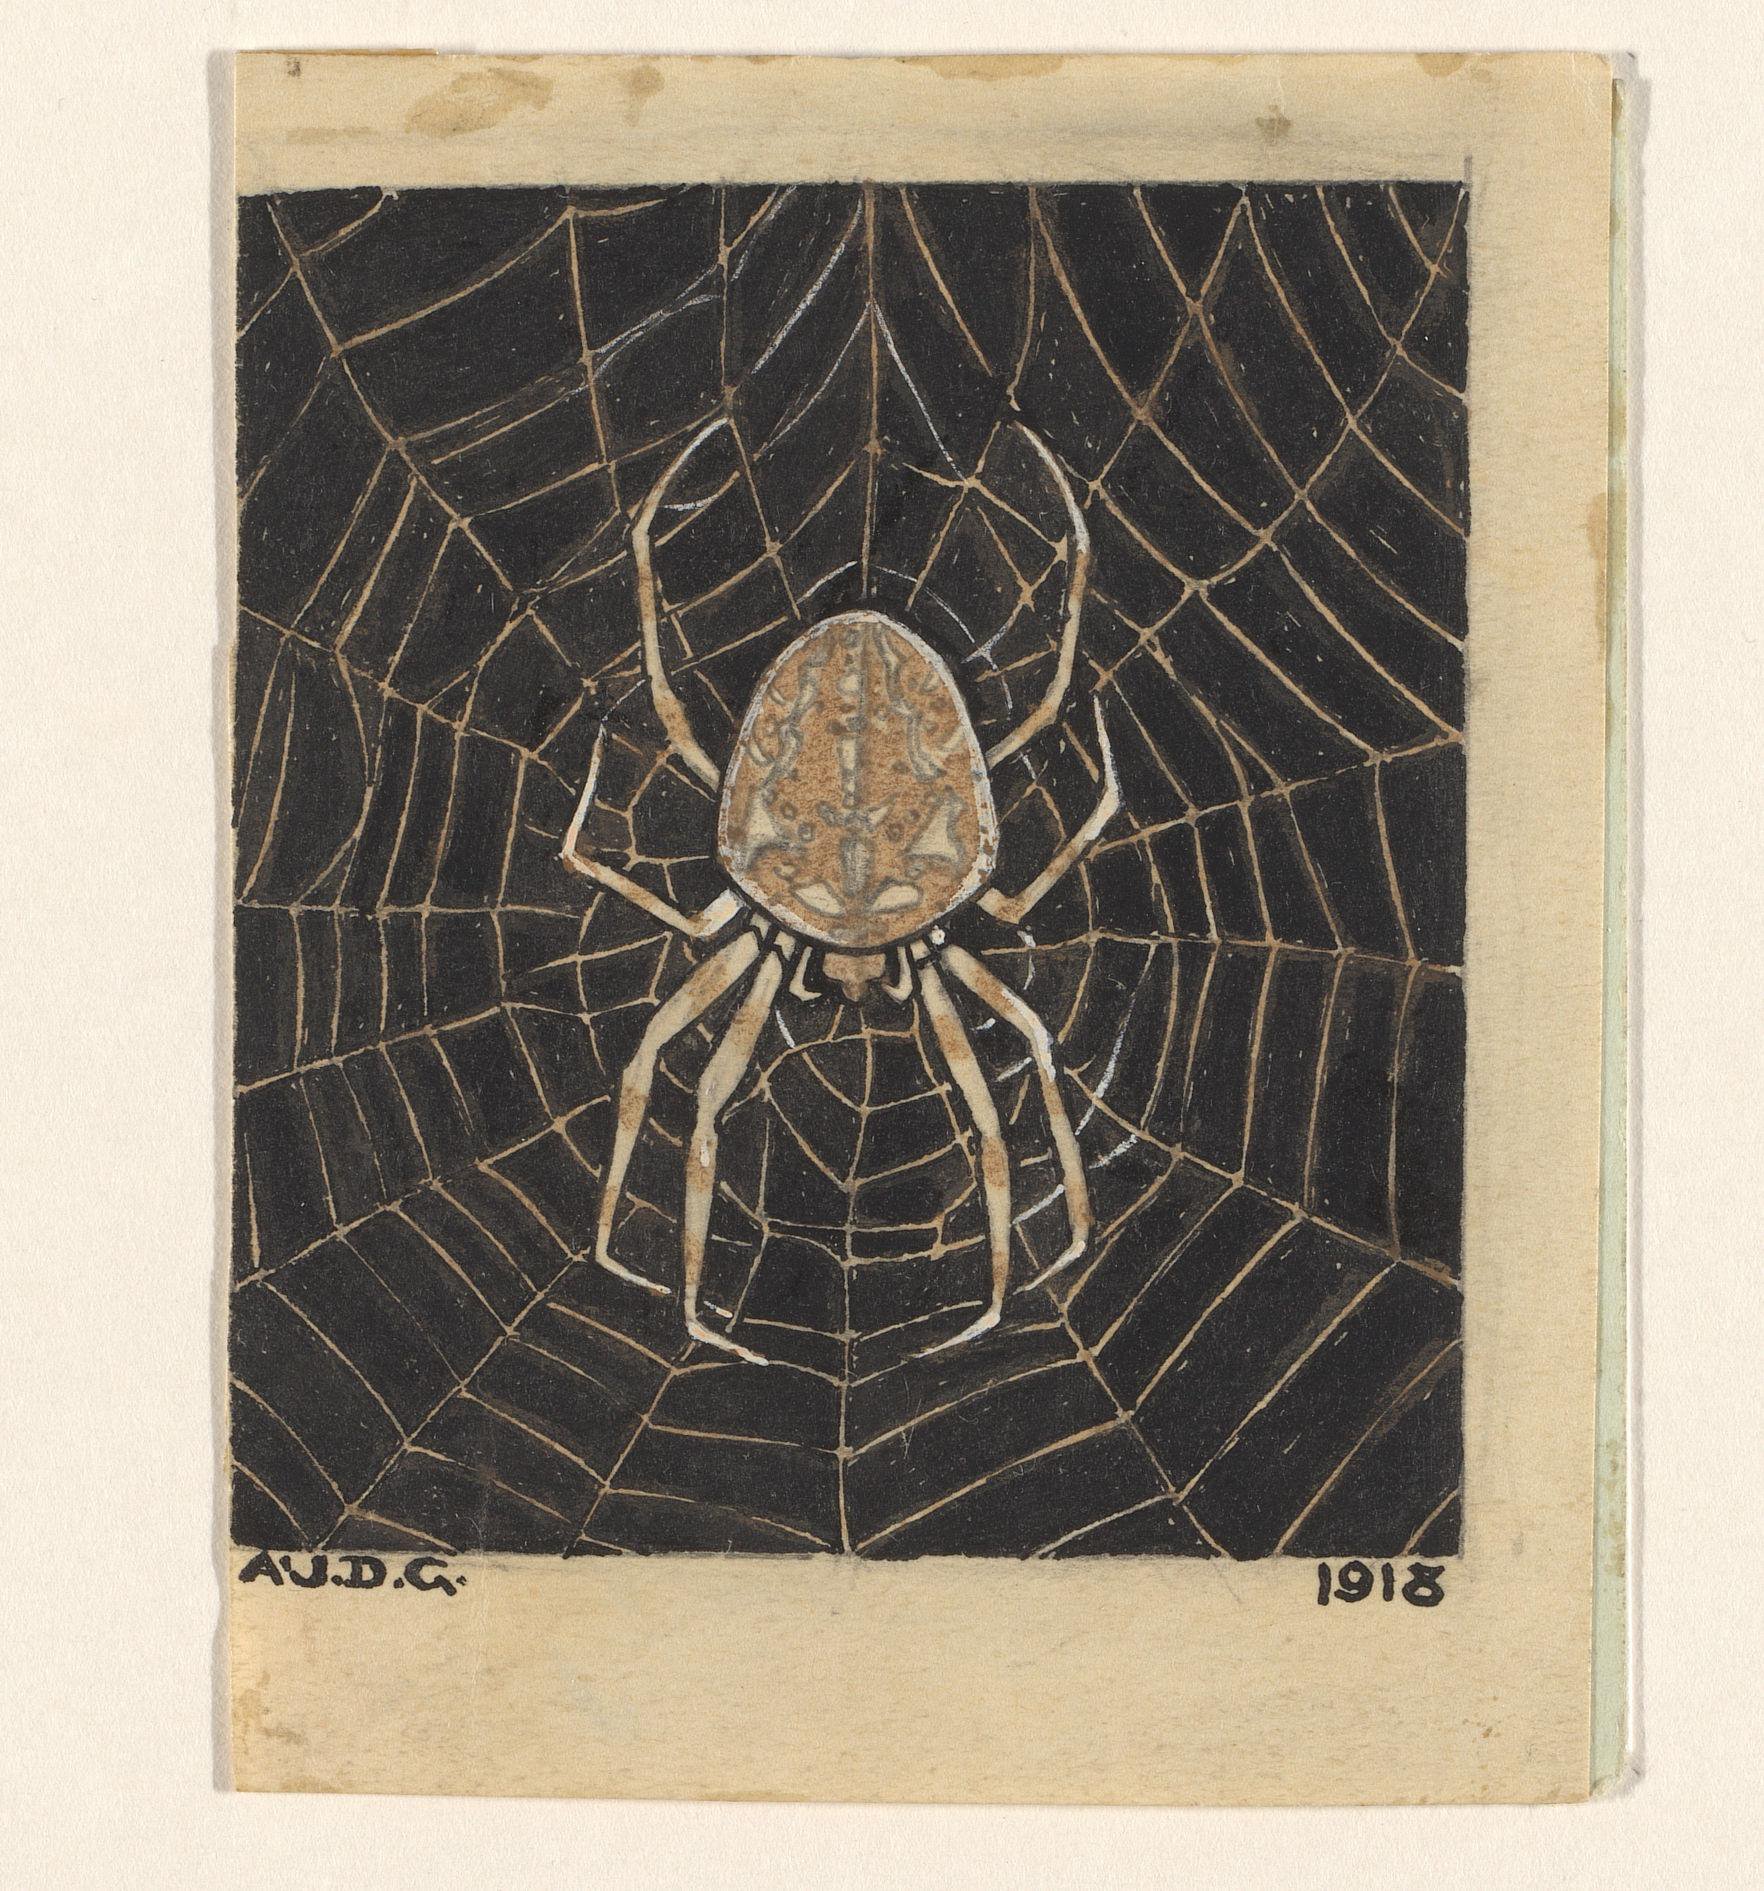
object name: drawing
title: Spin in een web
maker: julie de graag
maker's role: draughtsman, print maker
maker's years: 1877-1924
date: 1918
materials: paint, ink, paper, pencil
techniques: brush, pen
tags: spiders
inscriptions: number: ‘47’